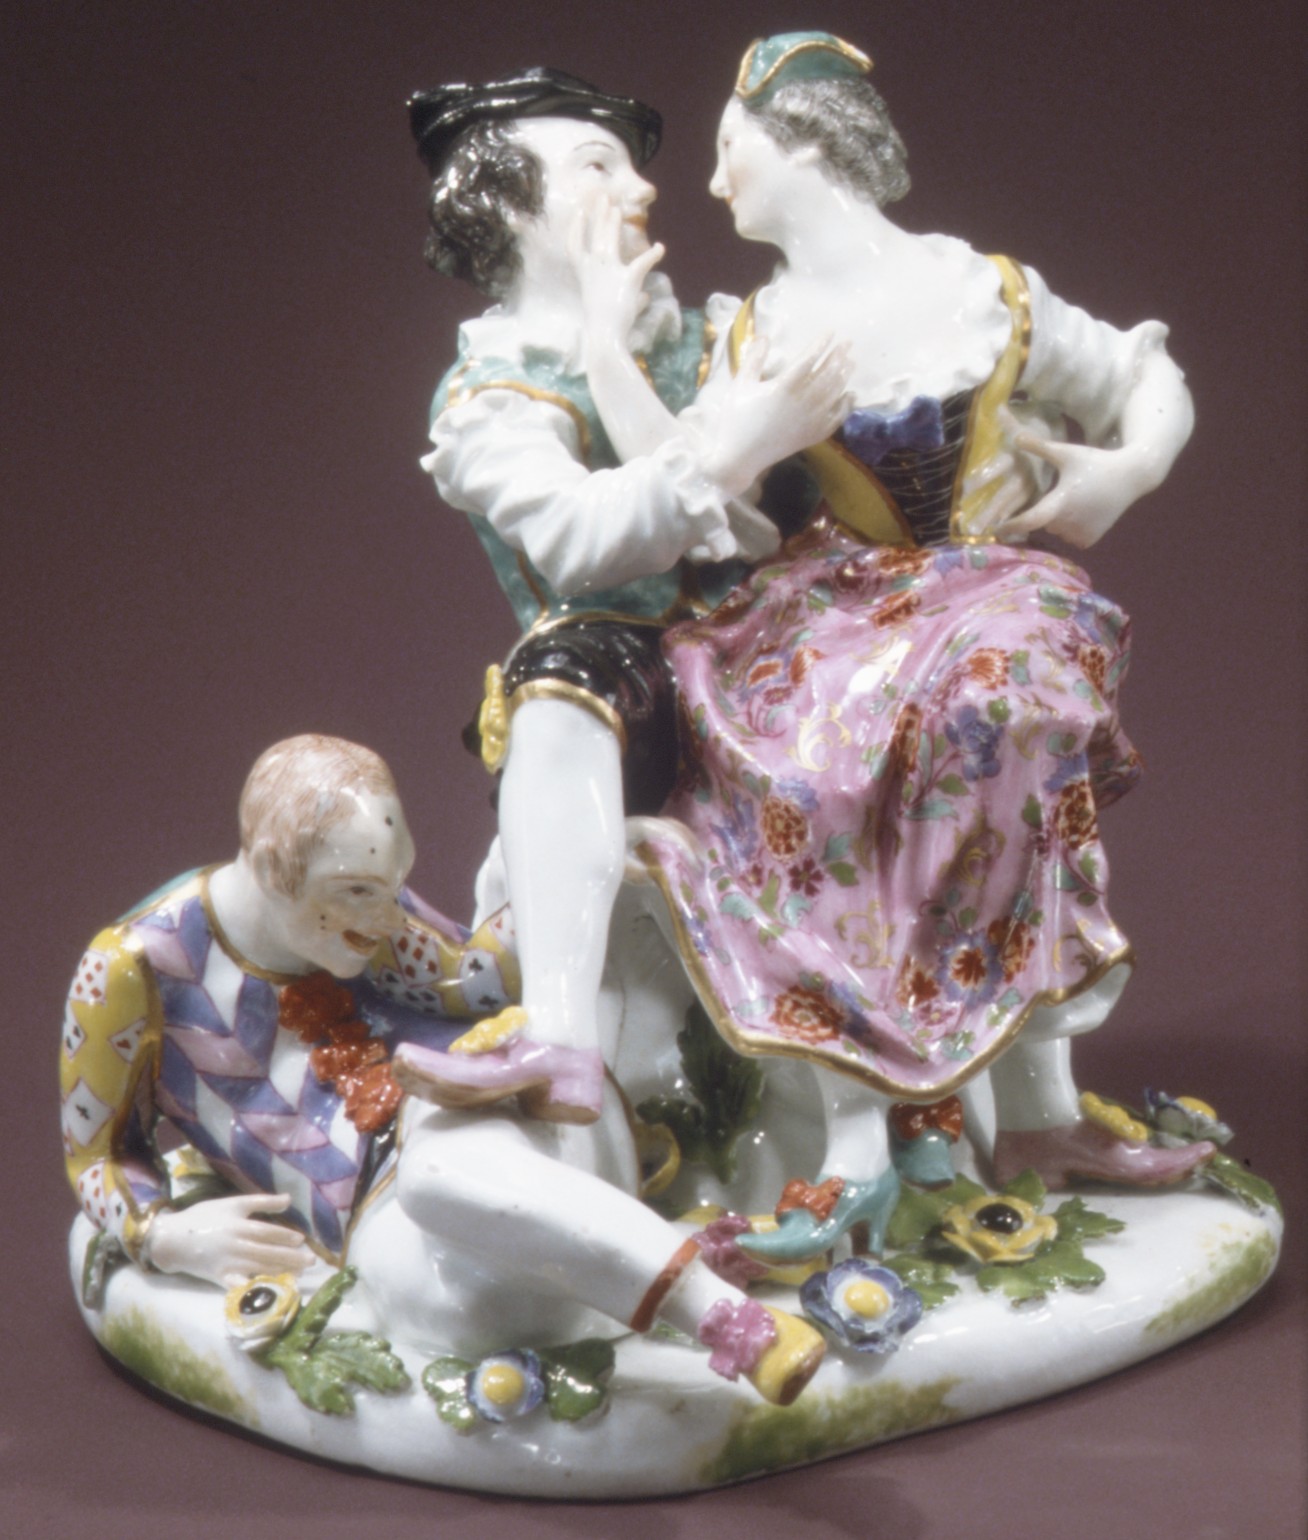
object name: group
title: Indiscreet Harlequin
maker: meissen manufactory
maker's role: manufactory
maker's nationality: german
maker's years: 1710-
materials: hard paste porcelain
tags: men,women